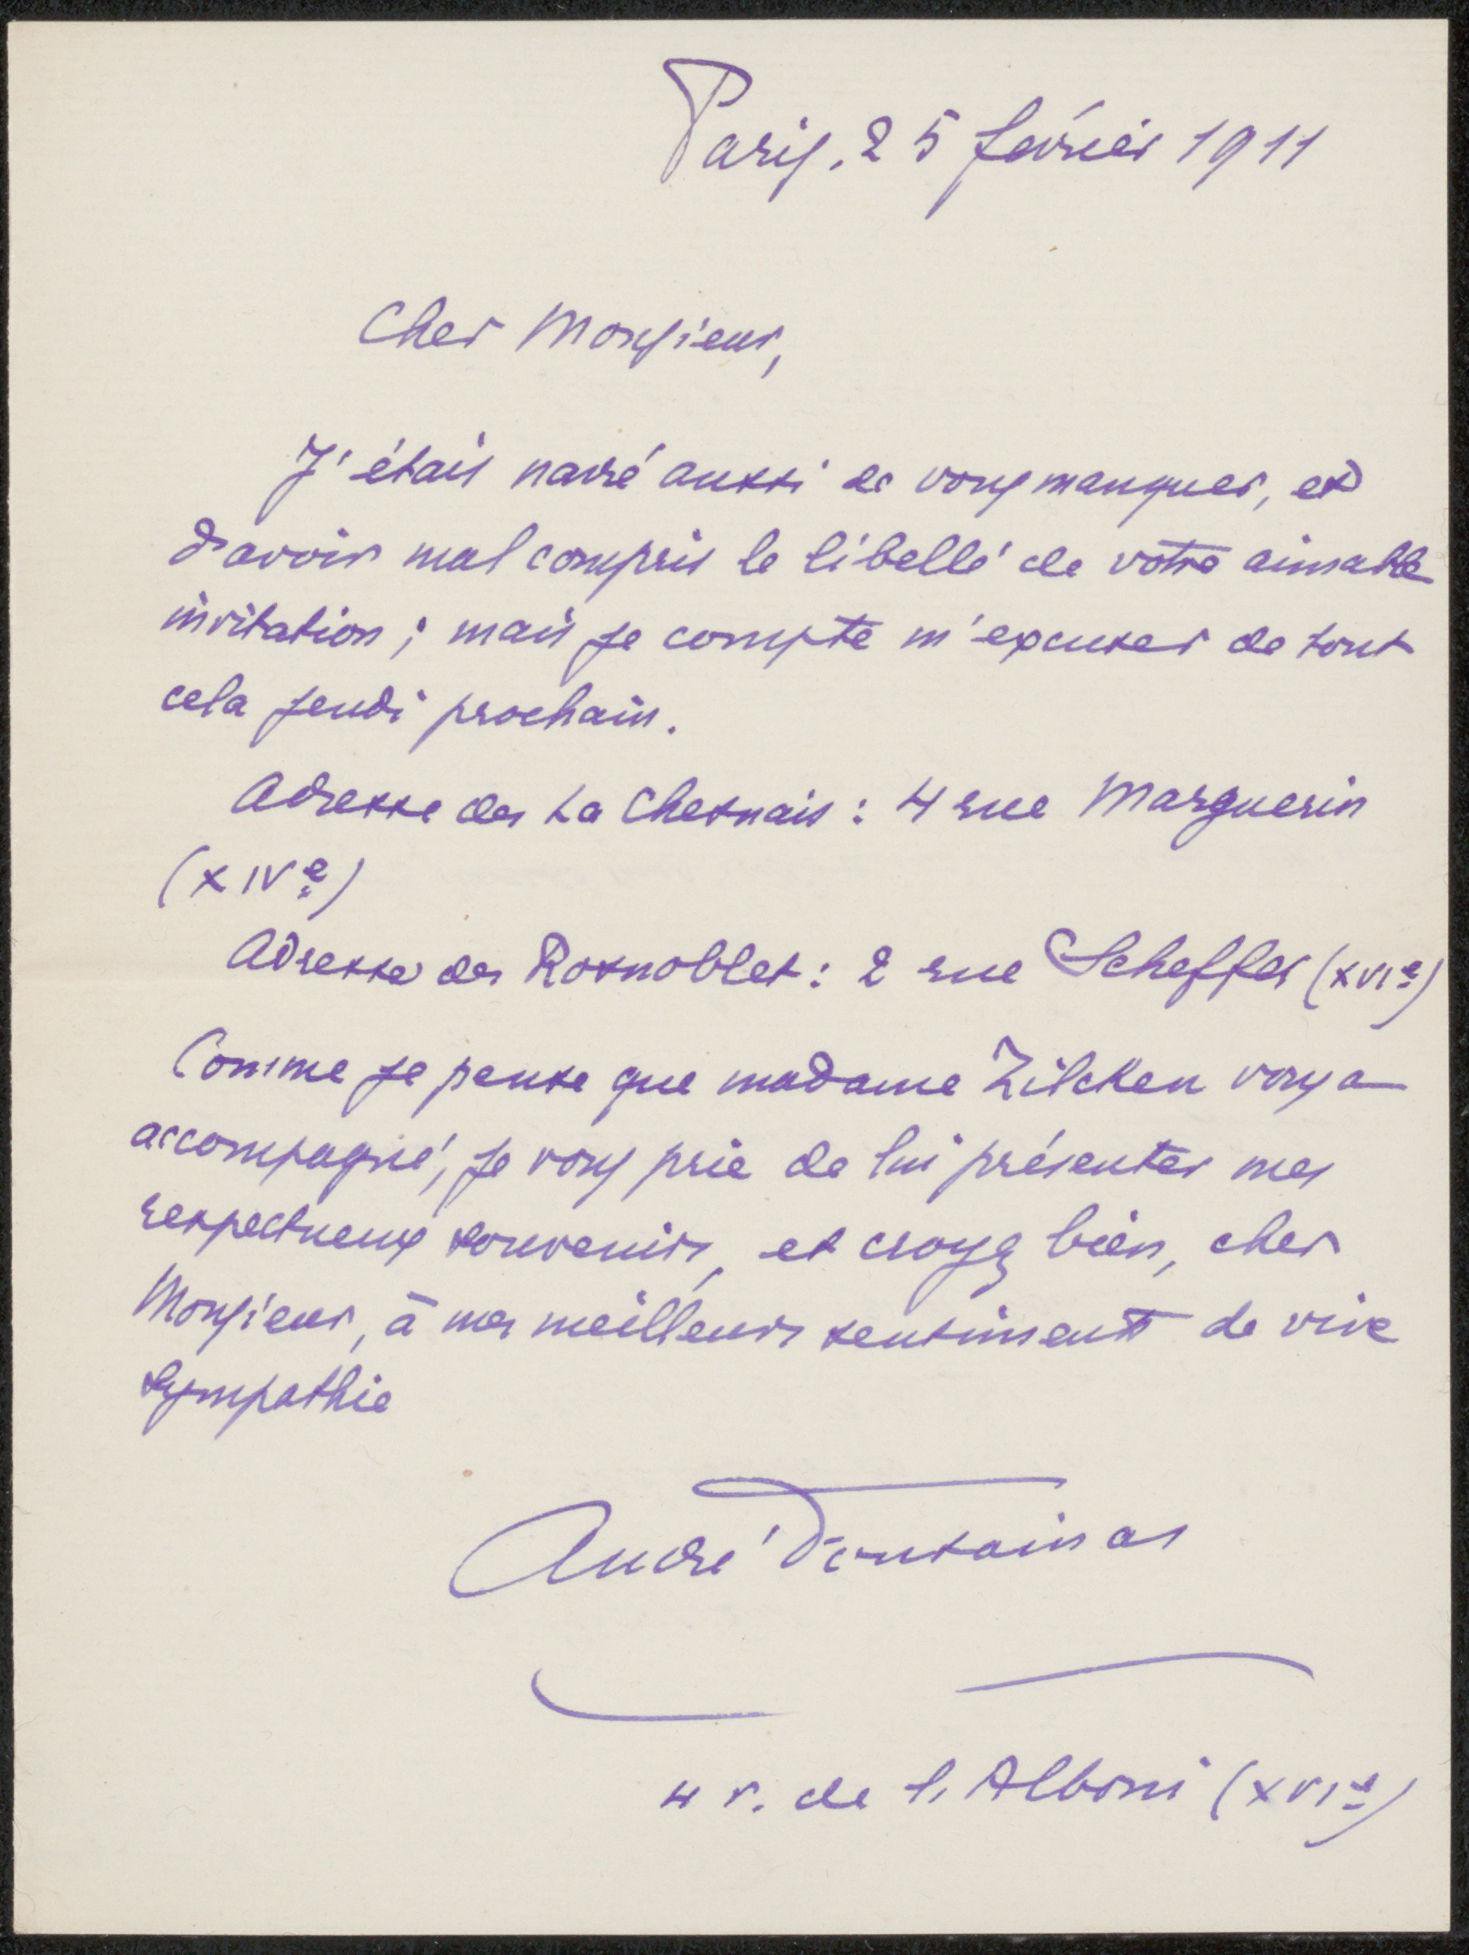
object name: letter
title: Brief aan Philip Zilcken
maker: andré fontainas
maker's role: criticus, dichter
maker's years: 1865-1948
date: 1911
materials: ink, paper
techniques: pen, writing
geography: paris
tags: the hague, painter, draughtsman, philip zilcken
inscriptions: collector's mark: ‘RPK’